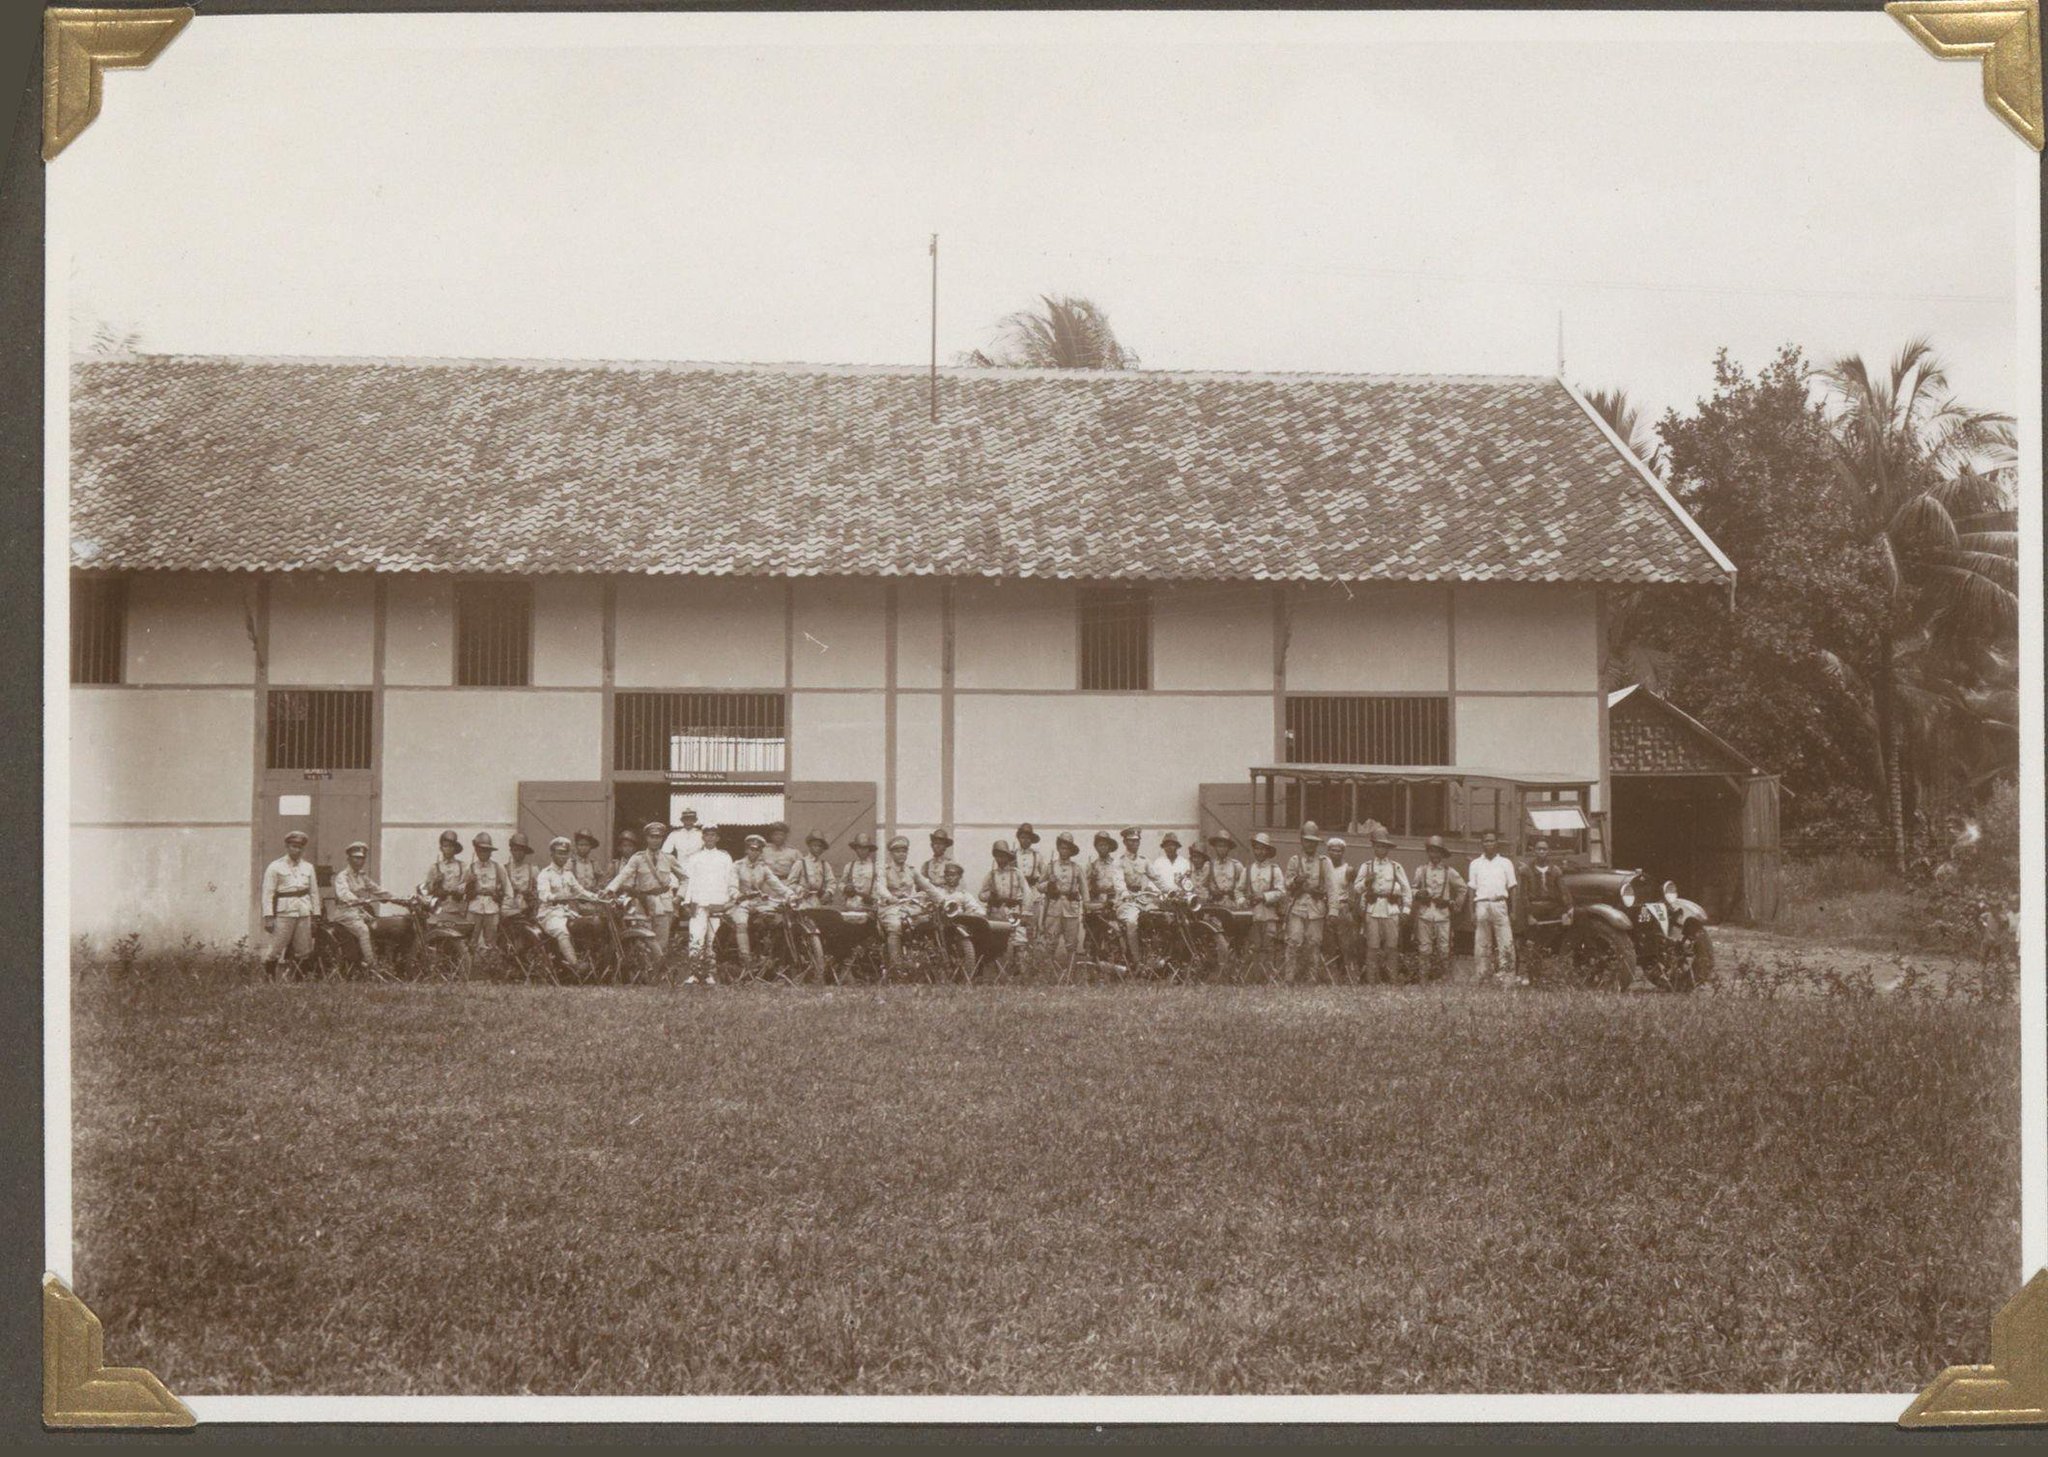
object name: photograph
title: De snelheid van optreden der Veldpolitie ligt in haar motorrijwielen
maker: Anonymous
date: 1932-1933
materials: photographic support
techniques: gelatin silver print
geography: lampung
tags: motor-cycles and other two-wheeled motor-vehicles, police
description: Onderdeel van Herinneringsalbum voor F.J. Junius, vertrekkend resident van Lampong (Zuid-Sumatra).